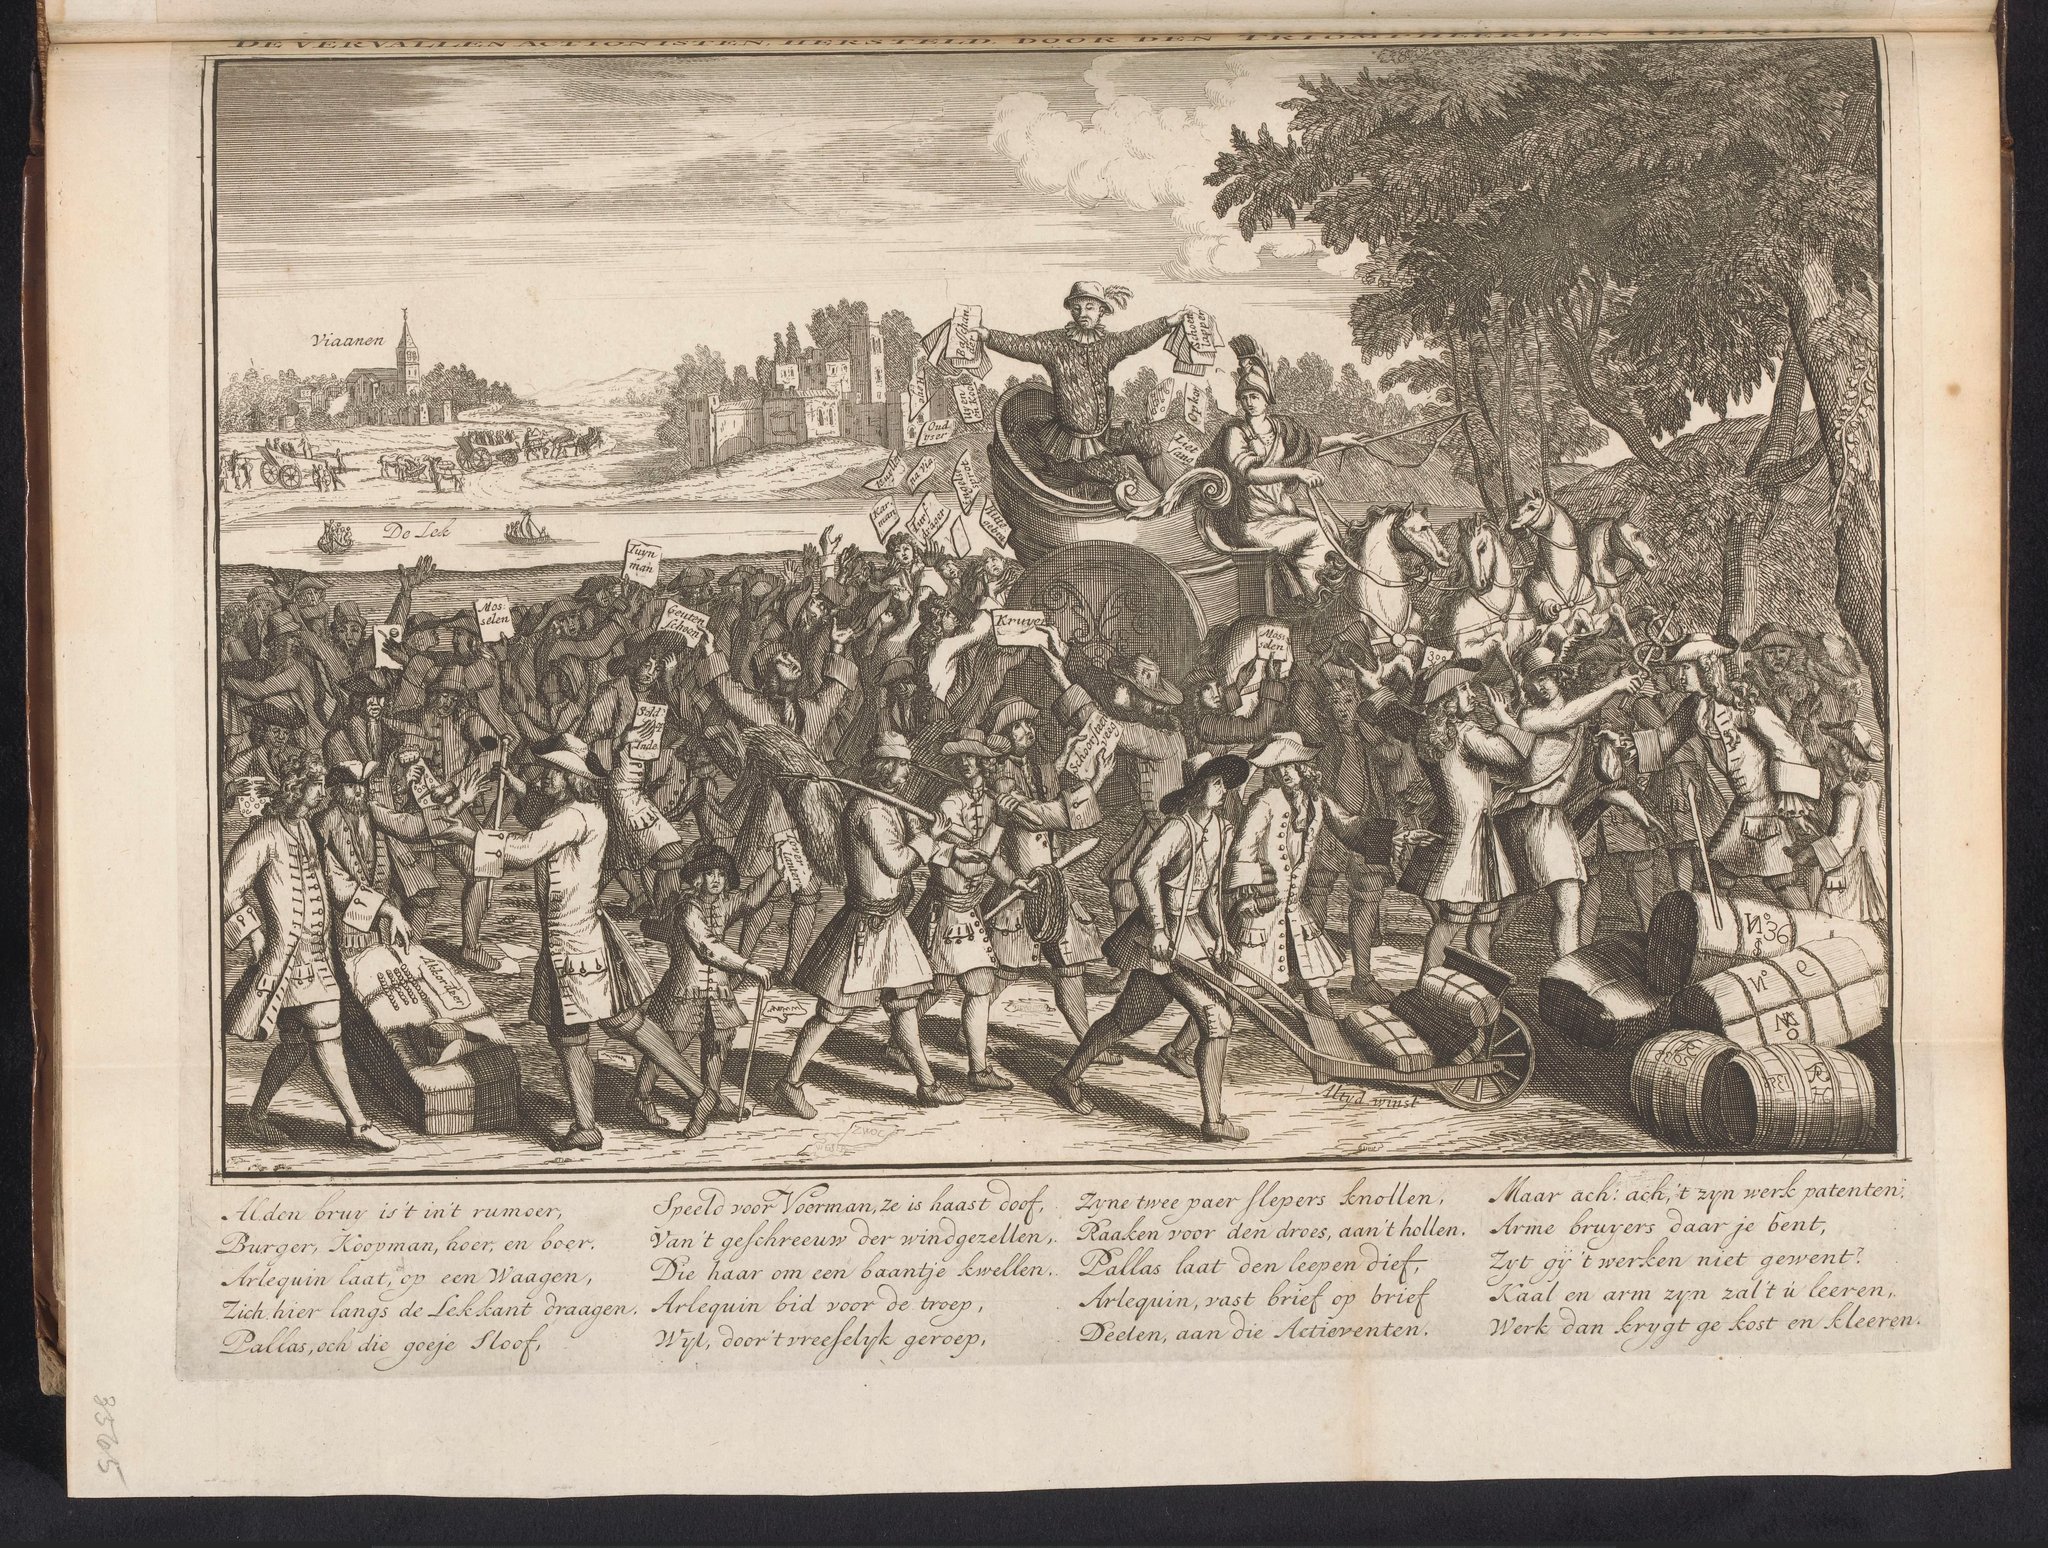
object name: print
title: De vervallen Actionisten, hersteld, door den Triompheerden Arlequin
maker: Anonymous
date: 1720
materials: paper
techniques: etching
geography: northern netherlands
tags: chariot, triumphal car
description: De triomferende Harlekijn en de Actionisten. Harlekijn strooit vanuit een wagen waardeloze aandelen tussen de handelaren in de windhandel. Op de achtergrond Vianen aan de Lek. In het onderschrift een vers in 4 kolommen. Prent in de gebonden eerste uitgave (304 B 11) van Het Groote Tafereel der Dwaasheid met spotprenten op de Windhandel of Actiehandel van 1720.